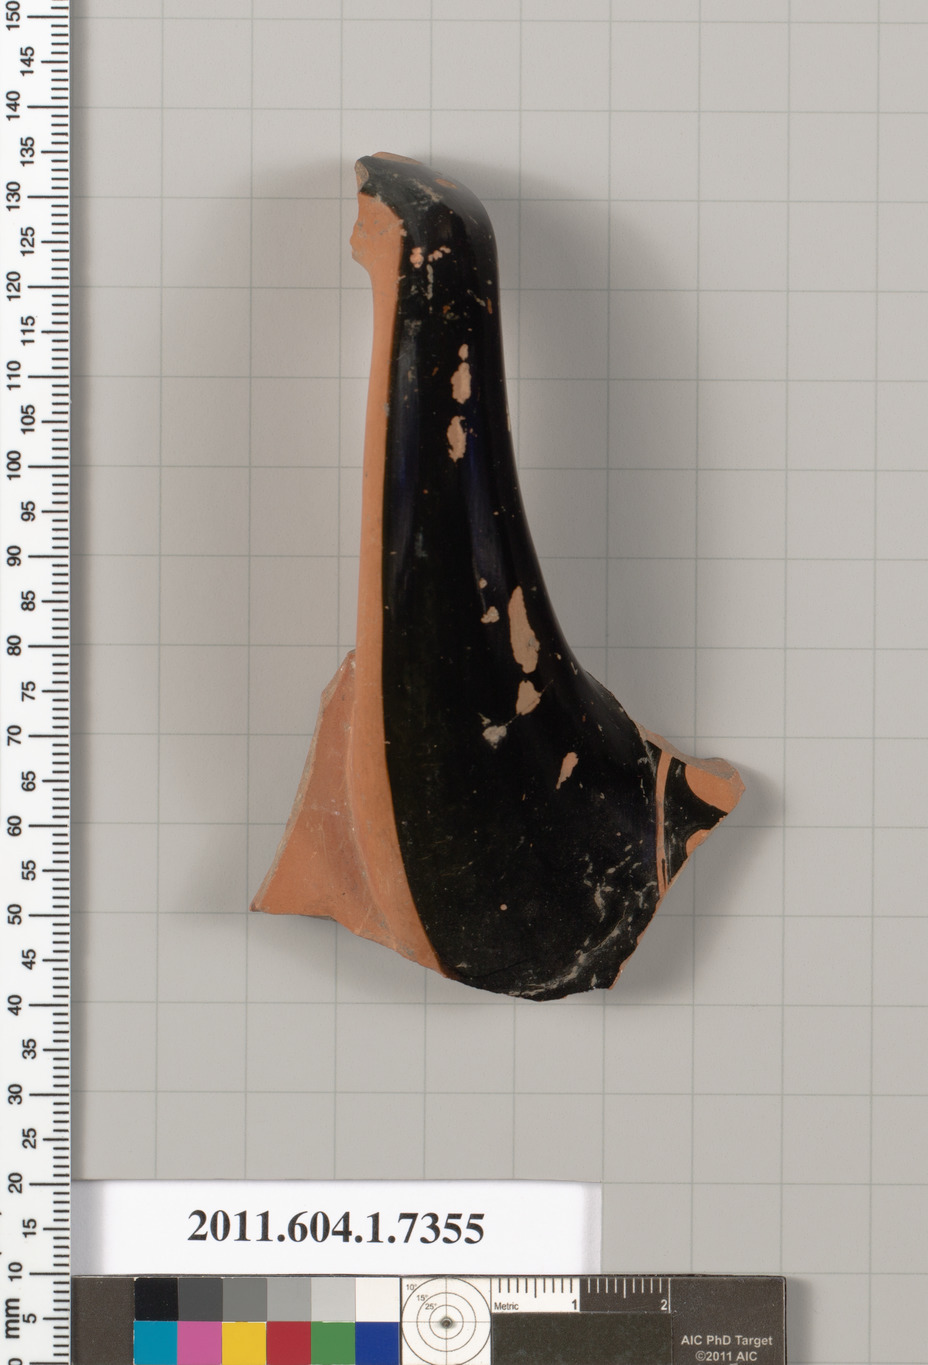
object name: kylix fragment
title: Terracotta fragment of a kylix (drinking cup)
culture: greek, attic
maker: makron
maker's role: artist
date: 500-480 BCE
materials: terracotta